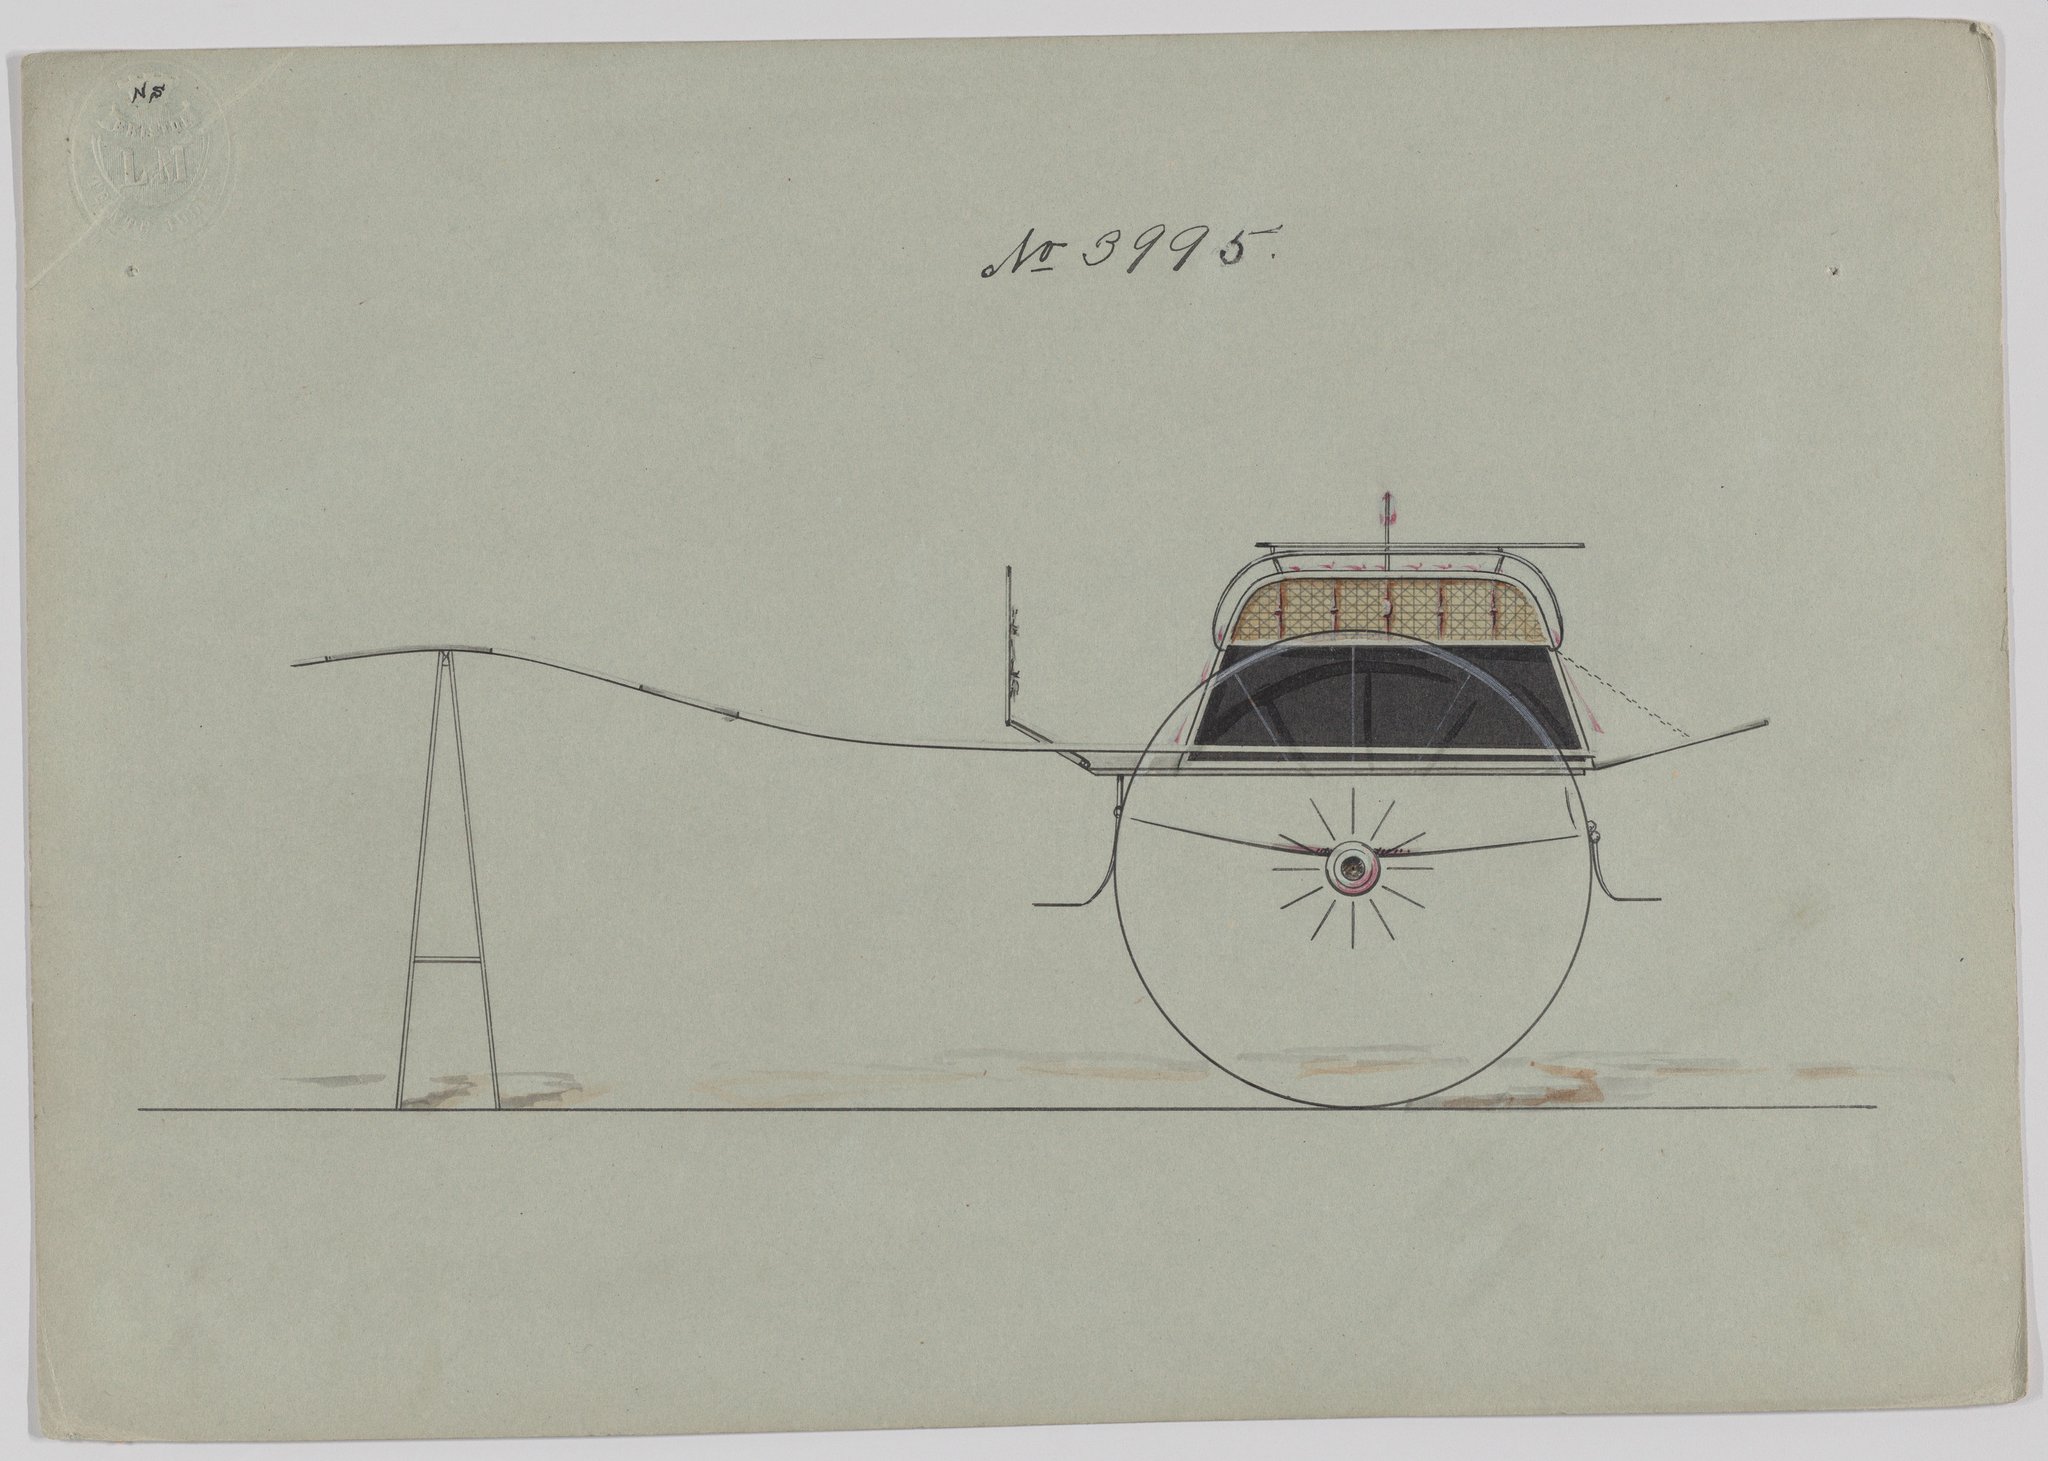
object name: drawing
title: Design for Dog Cart, no. 3995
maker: brewster & co.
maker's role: manufacturer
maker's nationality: american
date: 1887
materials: gouache, ink, watercolor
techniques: pen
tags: carriages